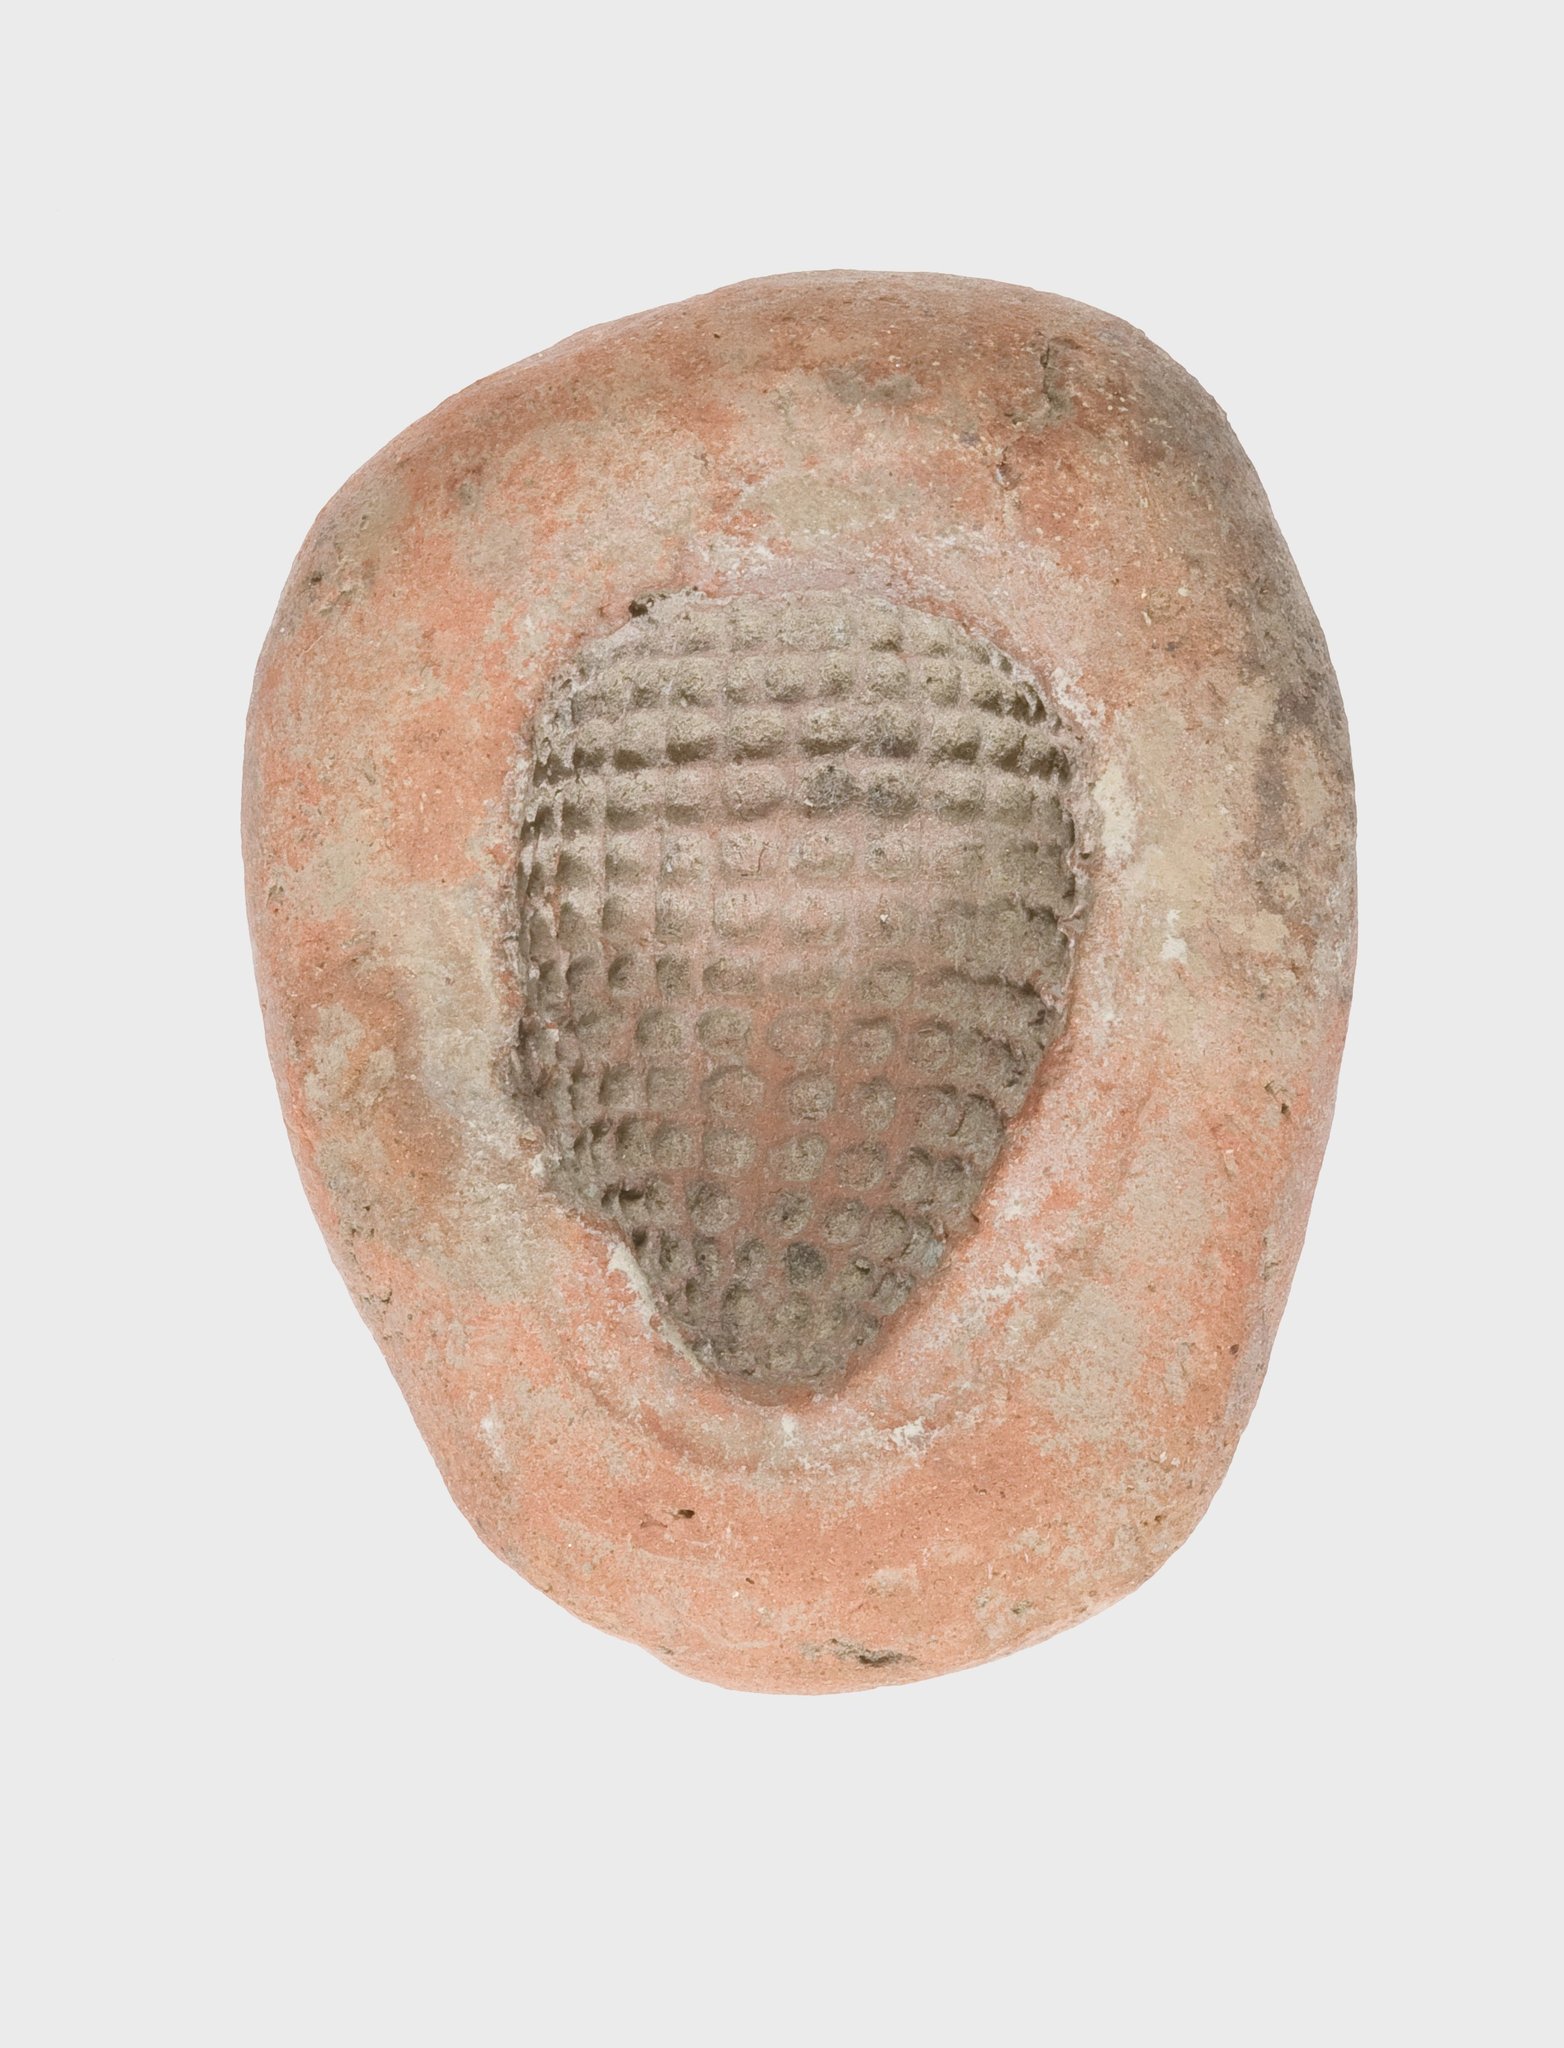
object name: mold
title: Mold for a Grape Inlay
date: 1390-1352 BCE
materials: pottery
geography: egypt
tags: grapes